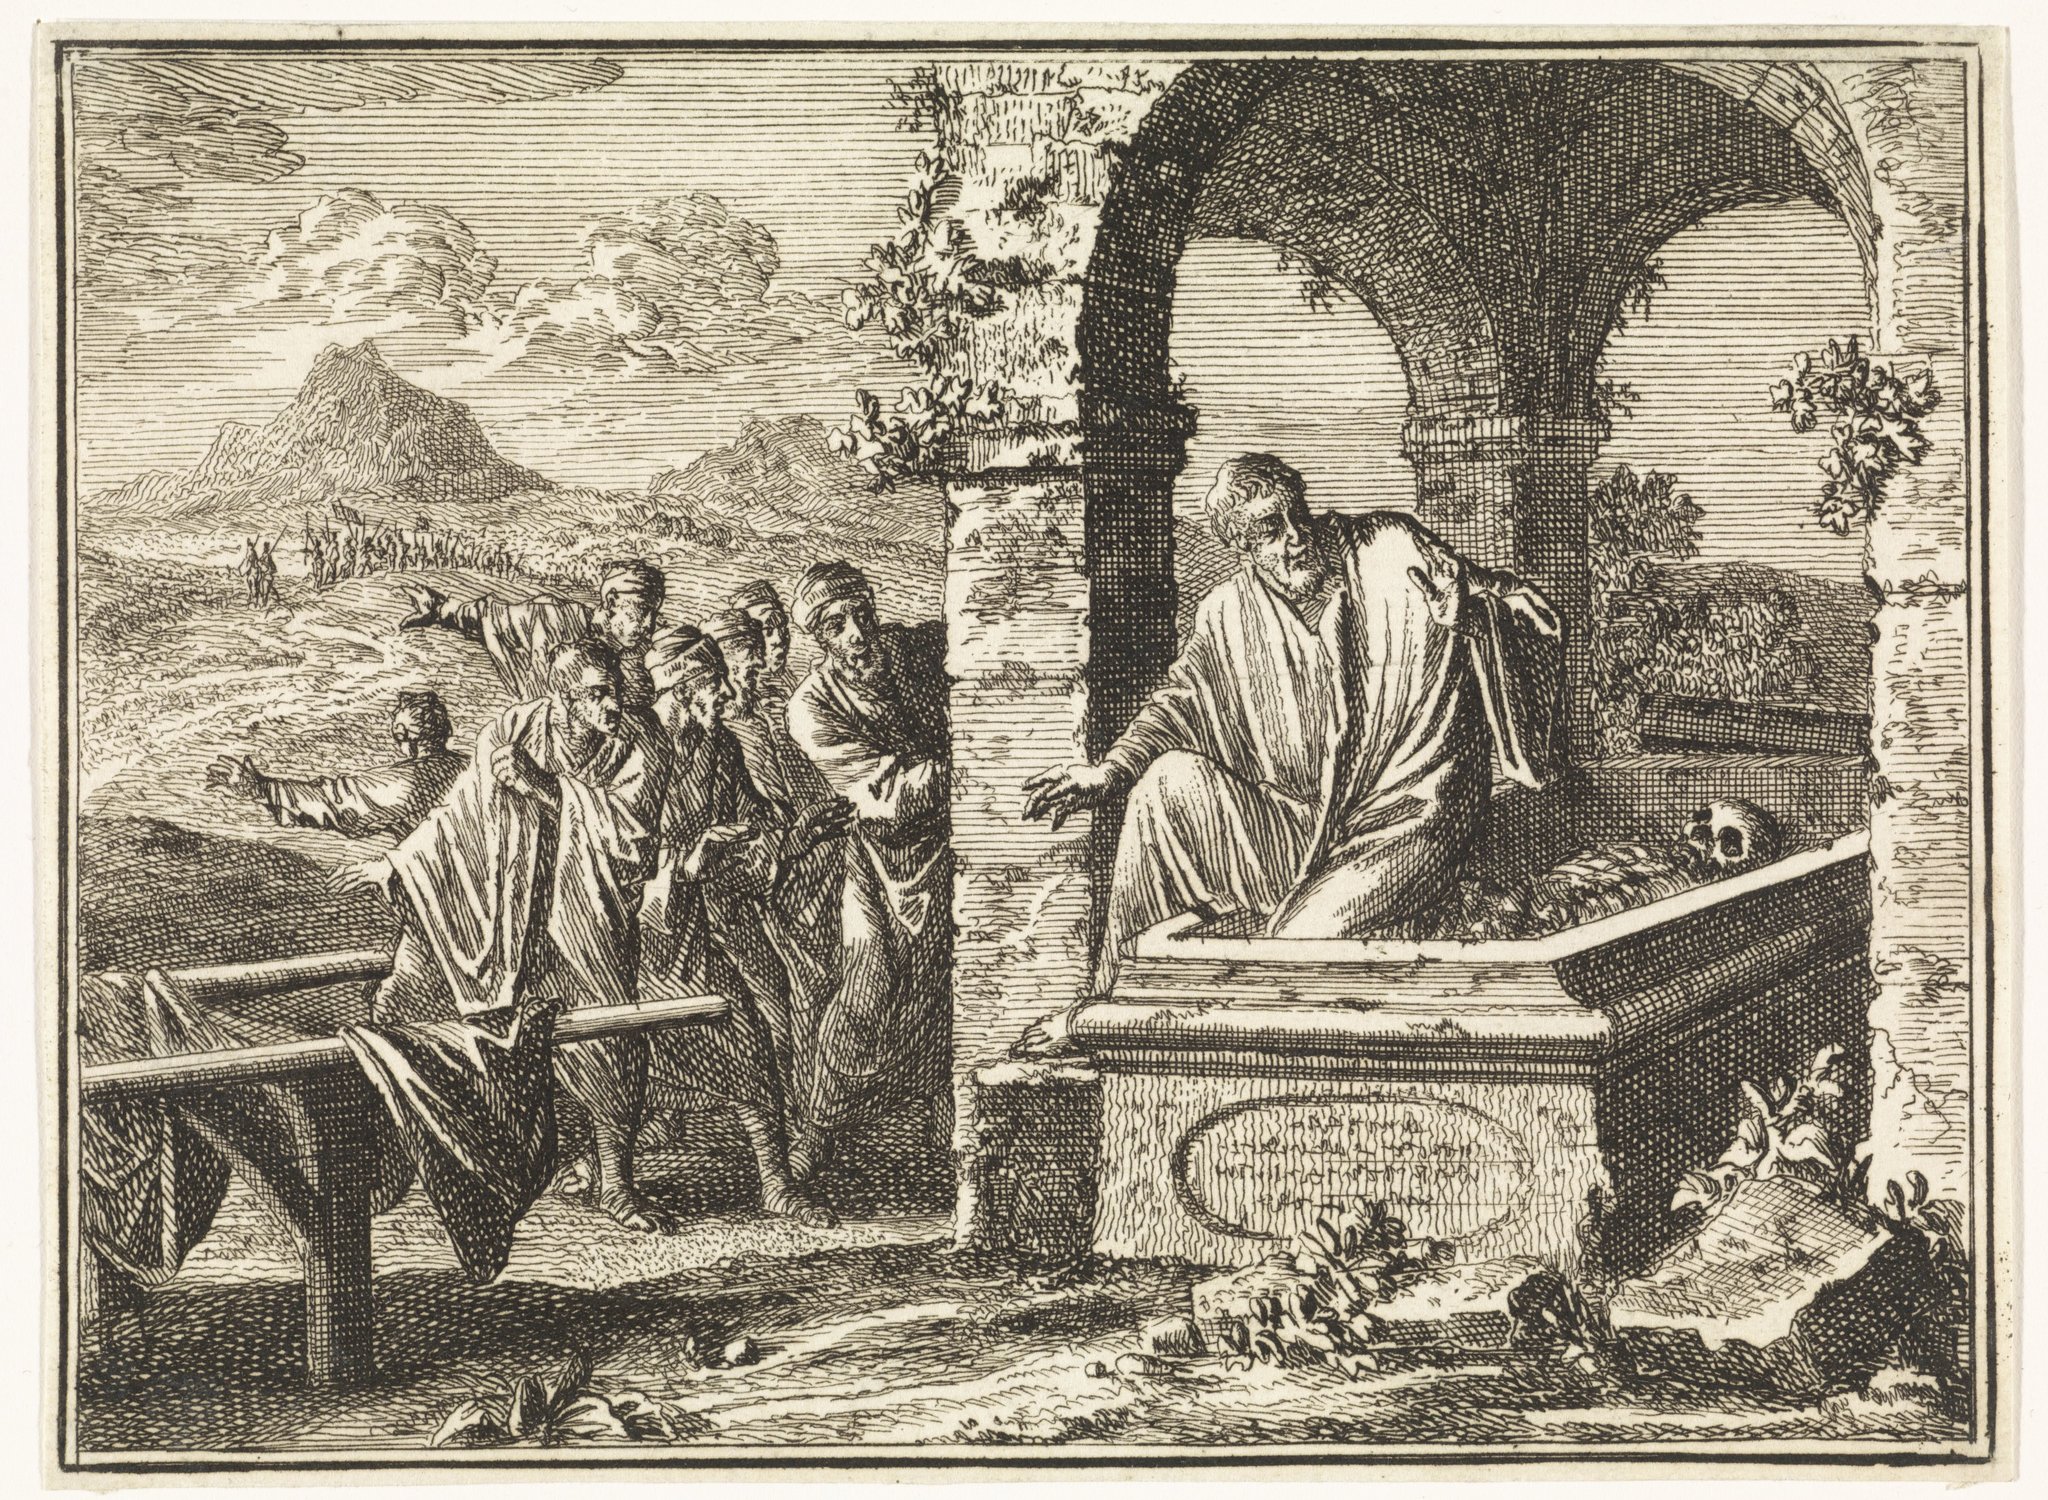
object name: print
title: Elisa's beenderen doen een overleden man tot leven komen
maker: jan luyken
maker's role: draughtsman, print maker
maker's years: 1649-1712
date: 1712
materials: paper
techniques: etching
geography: amsterdam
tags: during a funeral a band of ransacking moabites is seen approaching and the corpse is thrown hastily into elisha's tomb; when it touches elisha's bones the man comes back to life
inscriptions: collector's mark: Lugt 2228, number: ‘152’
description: Illustratie uit: Luyken, Jan. De schriftuurlyke geschiedenissen en gelykenissen van het Oude en Nieuwe Verbond, 2 delen. Amsterdam: Wed. Pieter Arentsz II en Cornelis van der Sys, 1712, dl. I.